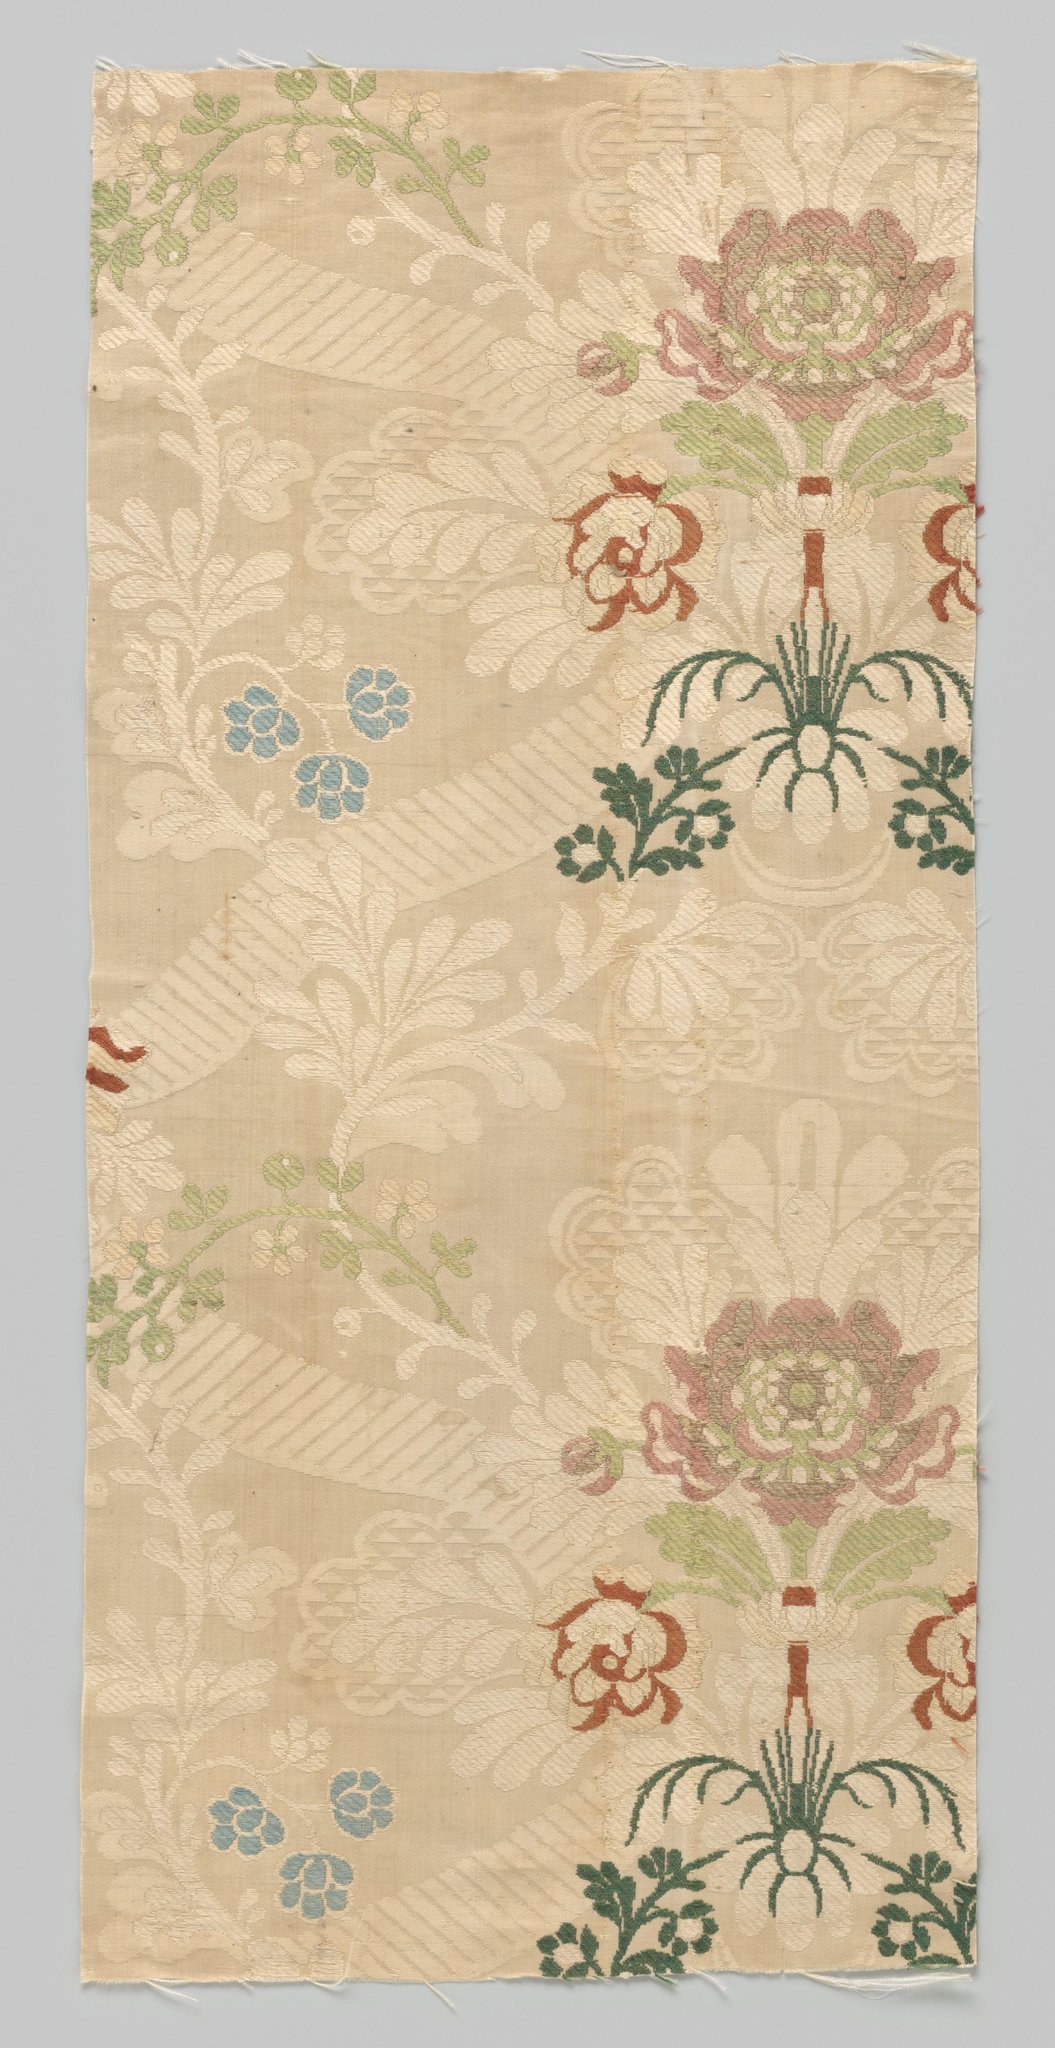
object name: woven material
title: Fragment van wit zijden damast met gekleurde bloemen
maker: Anonymous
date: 1730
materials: silk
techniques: damask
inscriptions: label: ‘Neerland. XVIII e. 3761’, label: ‘204’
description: Fragment van wit zijden damast met gekleurde bloemen. Nederland.